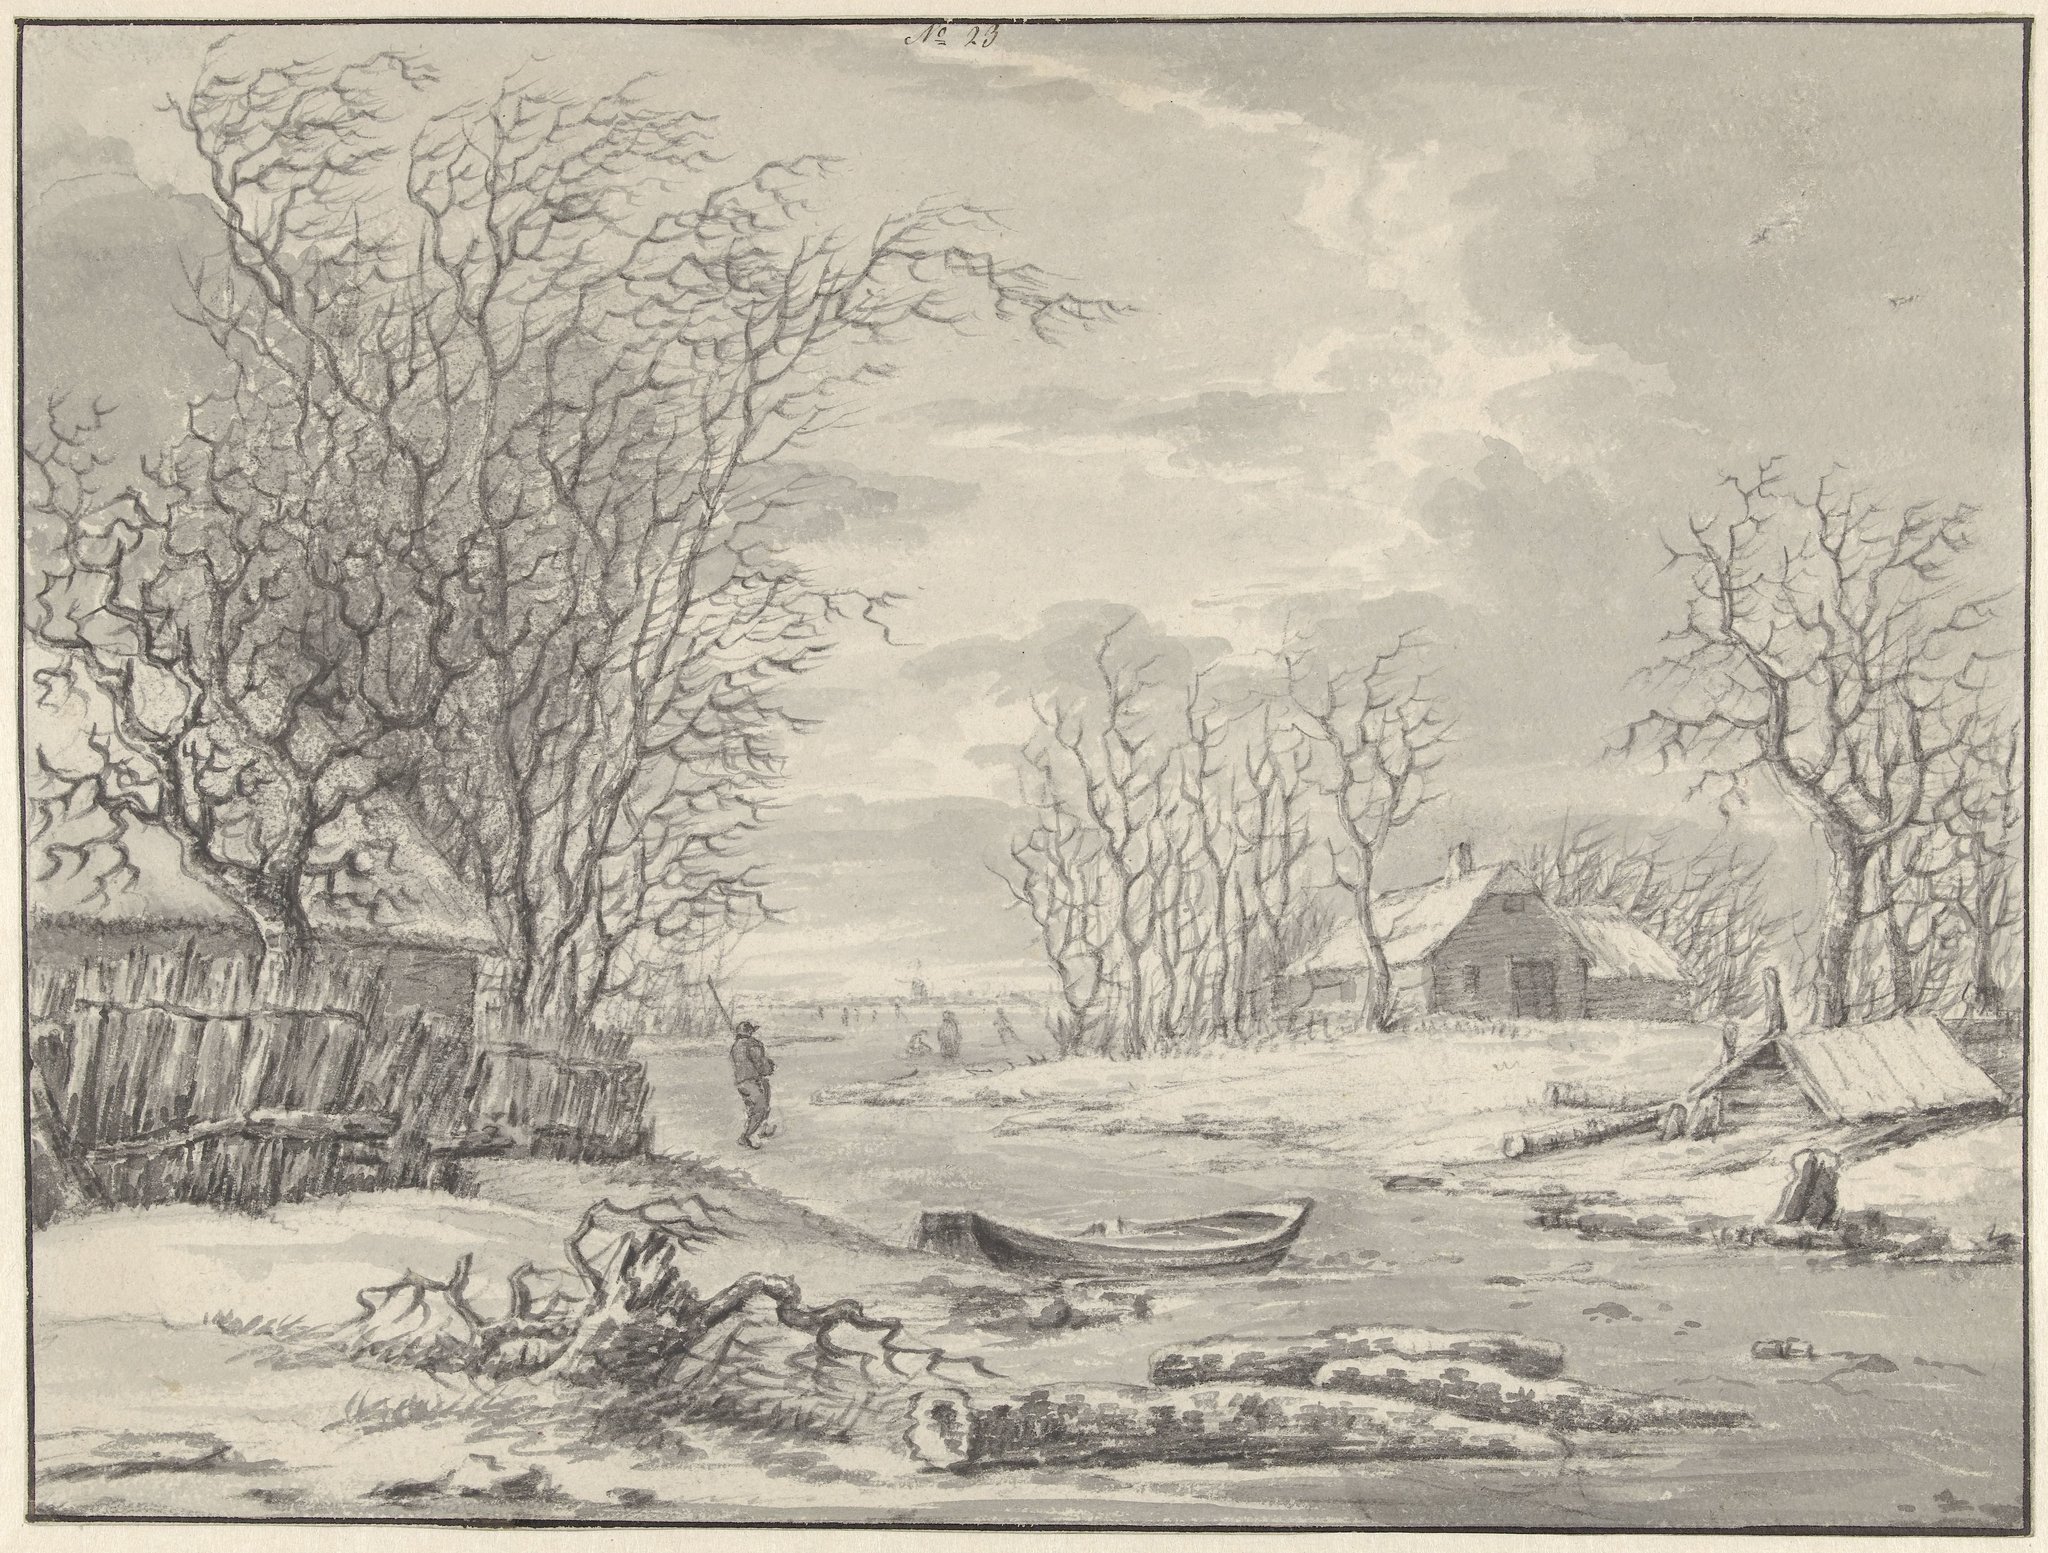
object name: drawing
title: Winterlandschap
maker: hendrik meijer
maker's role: draughtsman, print maker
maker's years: 1744-1793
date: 1754-1793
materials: chalk, paper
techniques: brush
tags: ice ~ freezing weather